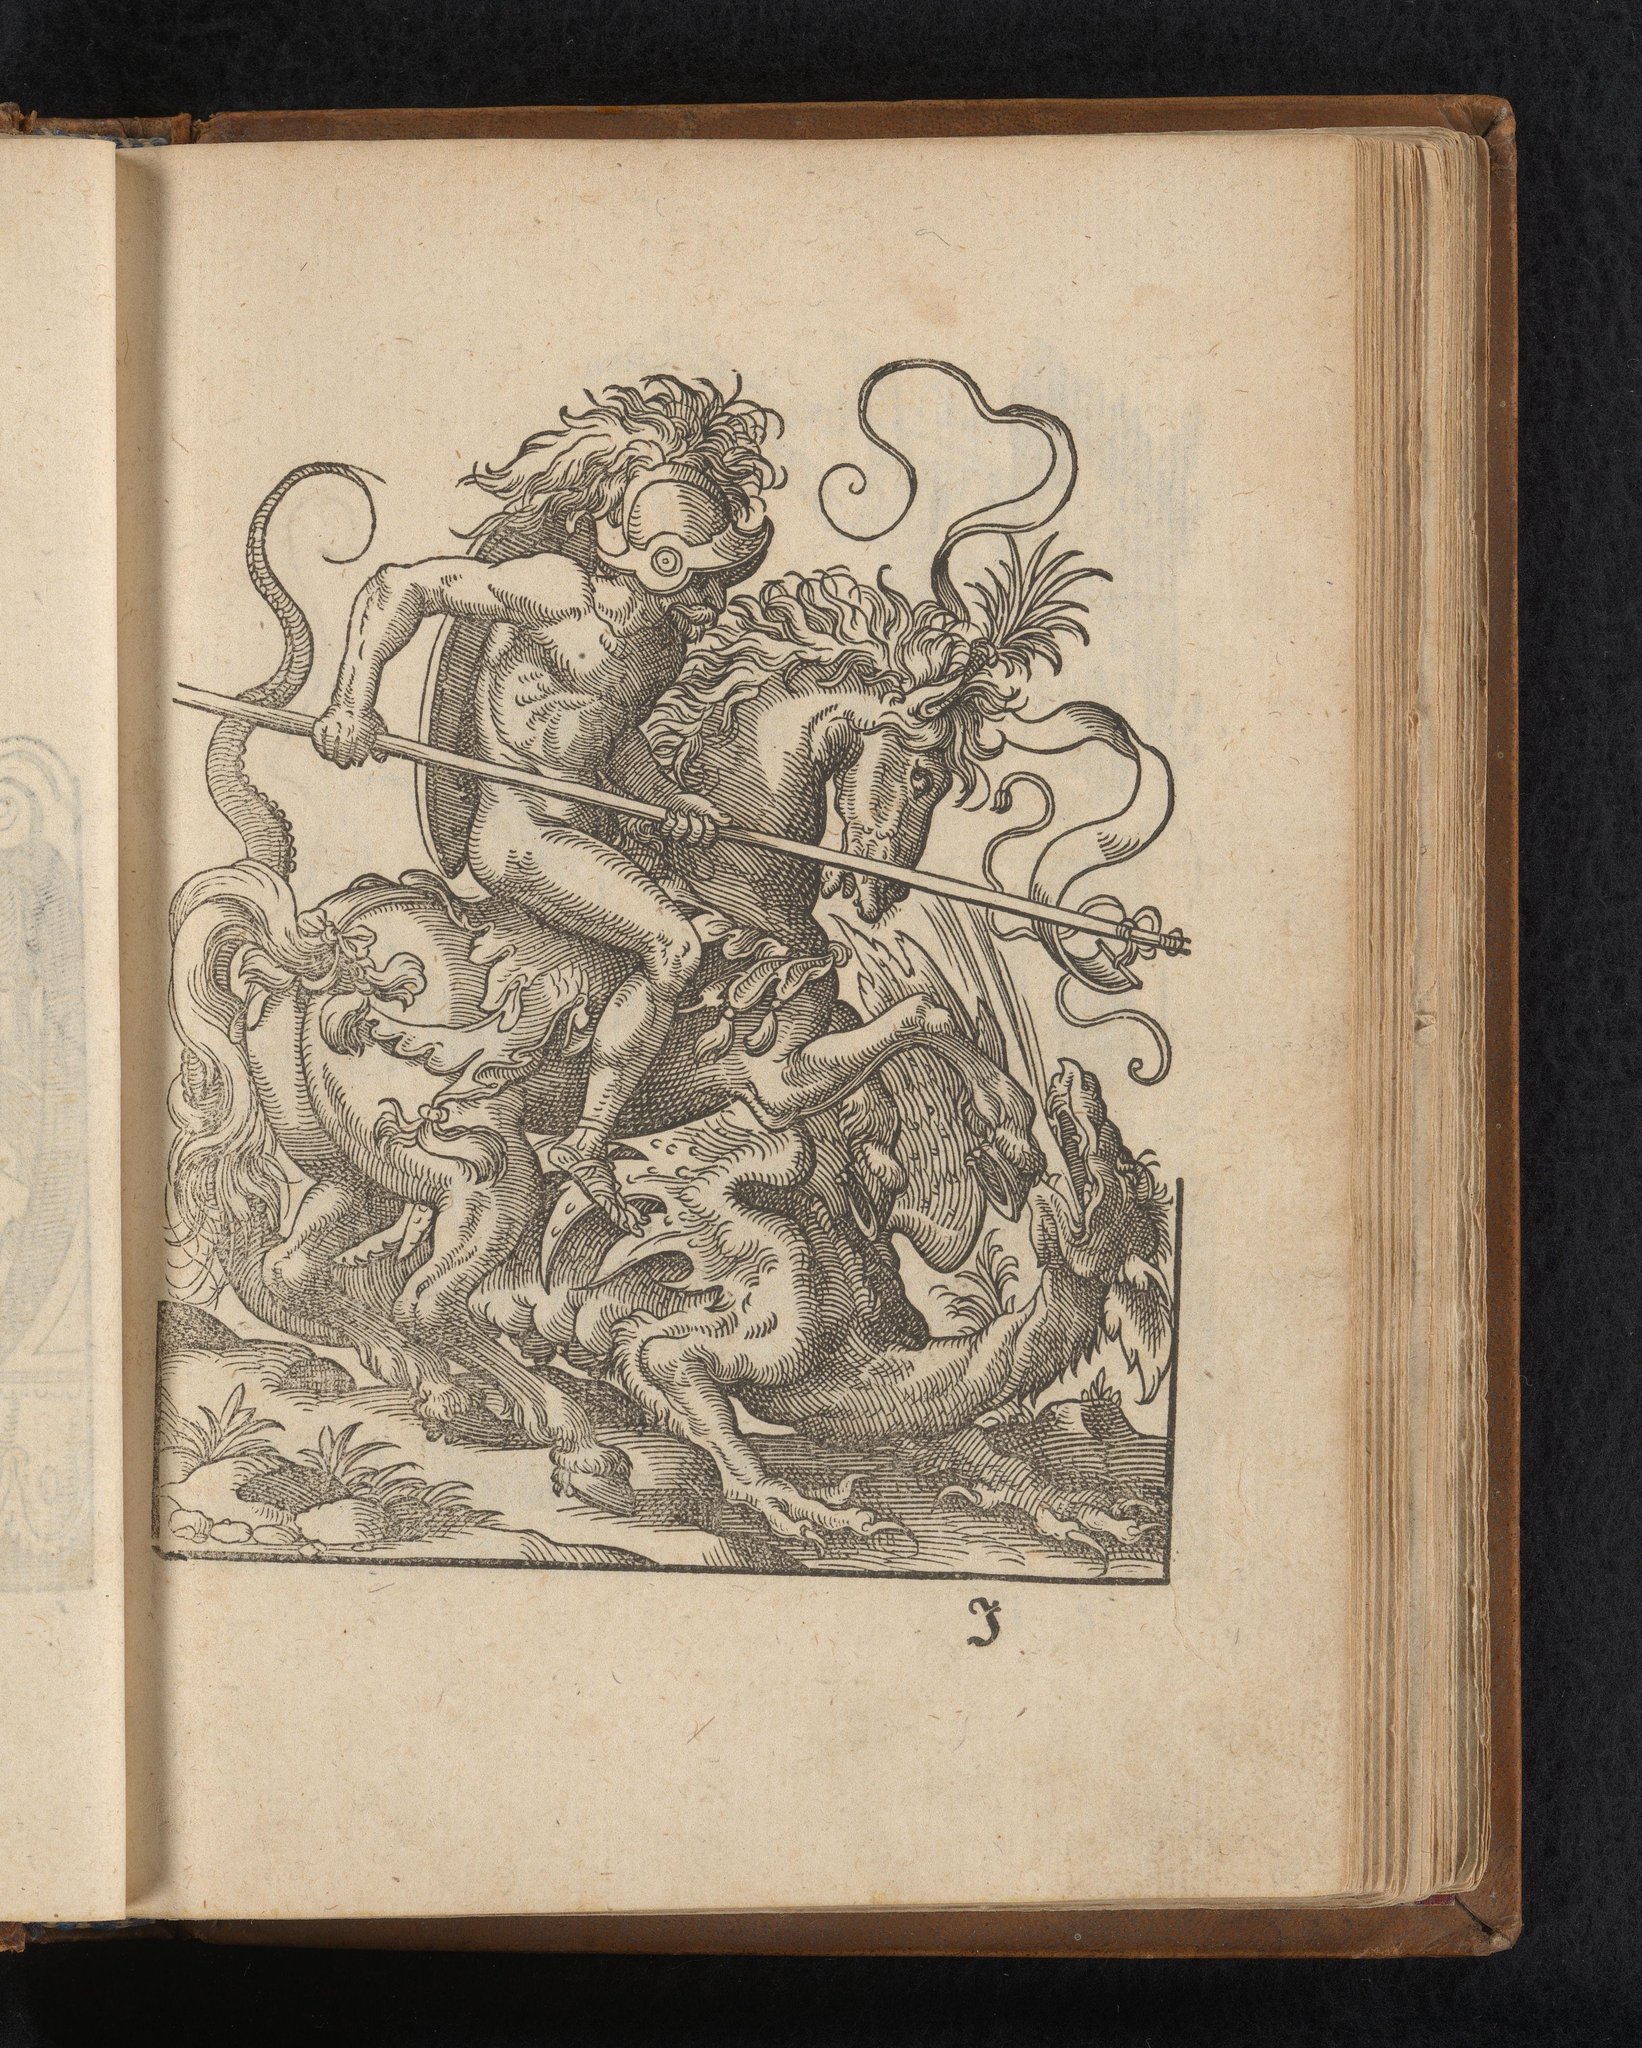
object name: print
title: H. Joris en de draak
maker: Anonymous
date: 1578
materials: paper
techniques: woodcut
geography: nuremberg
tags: st. george and the dragon: dressed in armour and mounted on a (white) horse he brandishes his sword (his lance lies already broken on the ground); the princess nearby may be shown praying or fleeing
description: Een naakte H. Joris te paard in gevecht met de draak. Onderdeel van het modelboek Enchiridion artis pingendi, fingendi & sculpendi met 108 figuren bedoeld voor beginnende schilders, beeldhouwers en prentmakers.